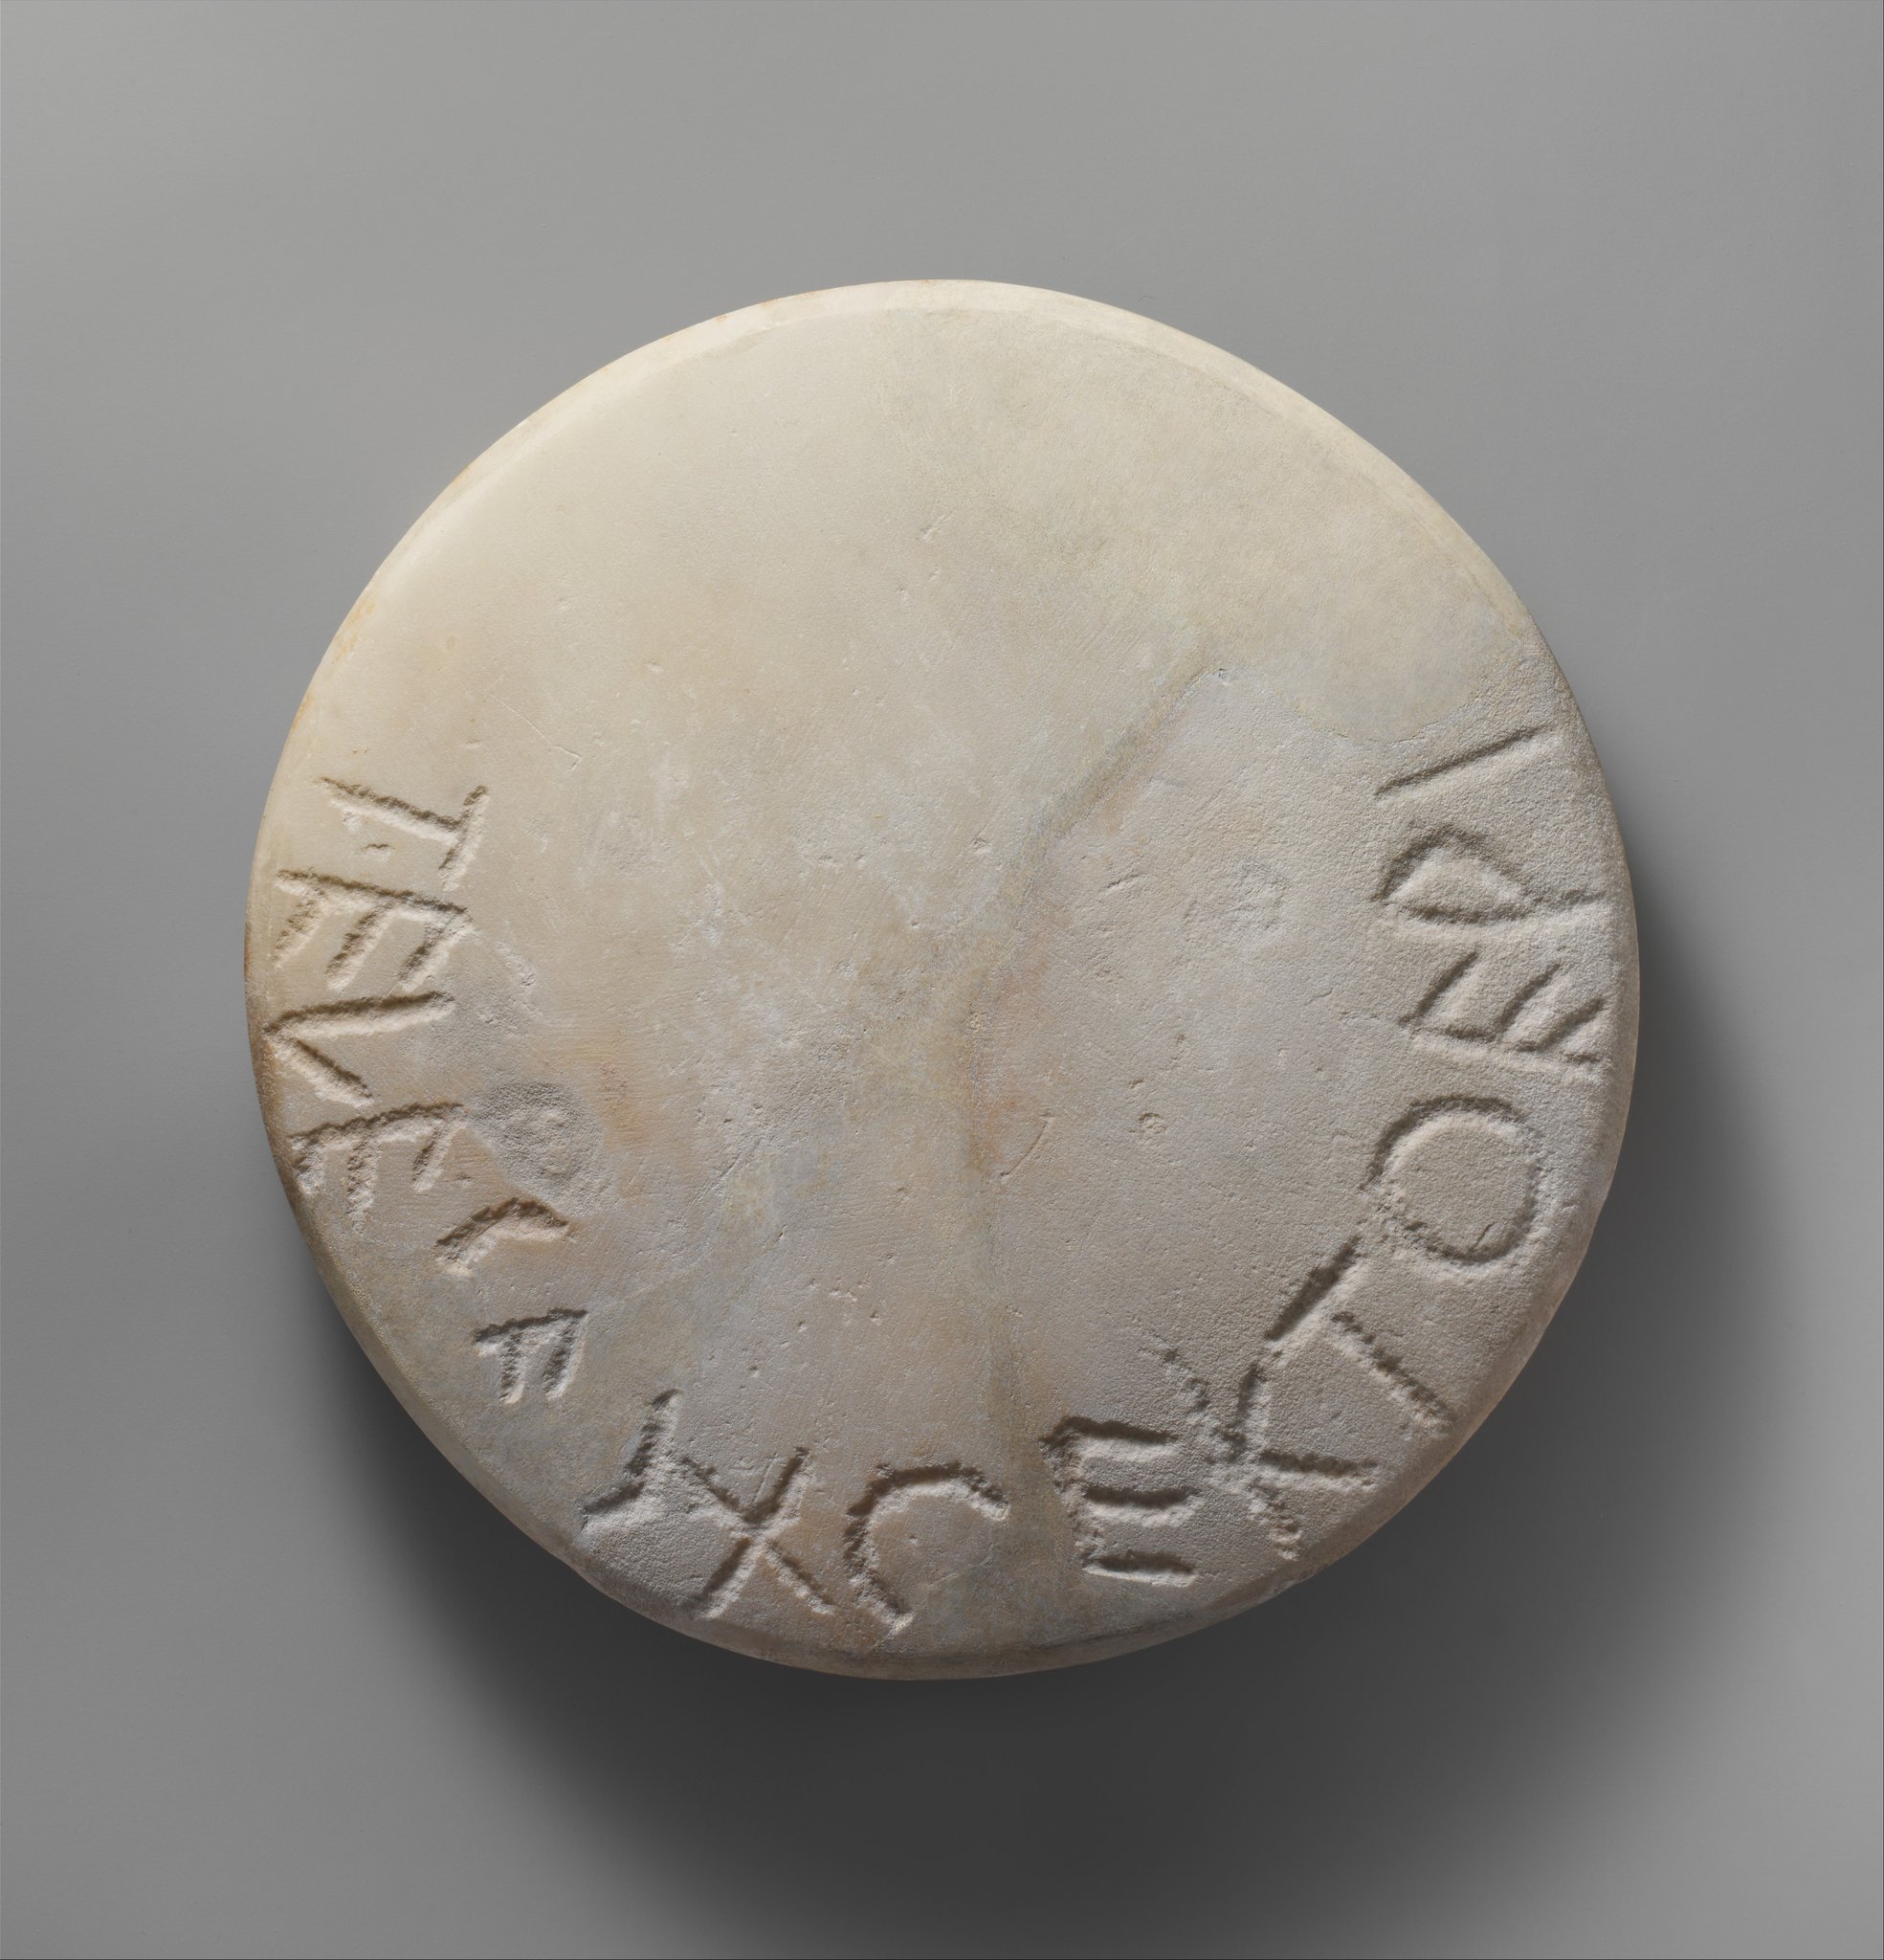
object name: diskos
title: Marble diskos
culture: greek, attic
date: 600-501 BCE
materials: marble